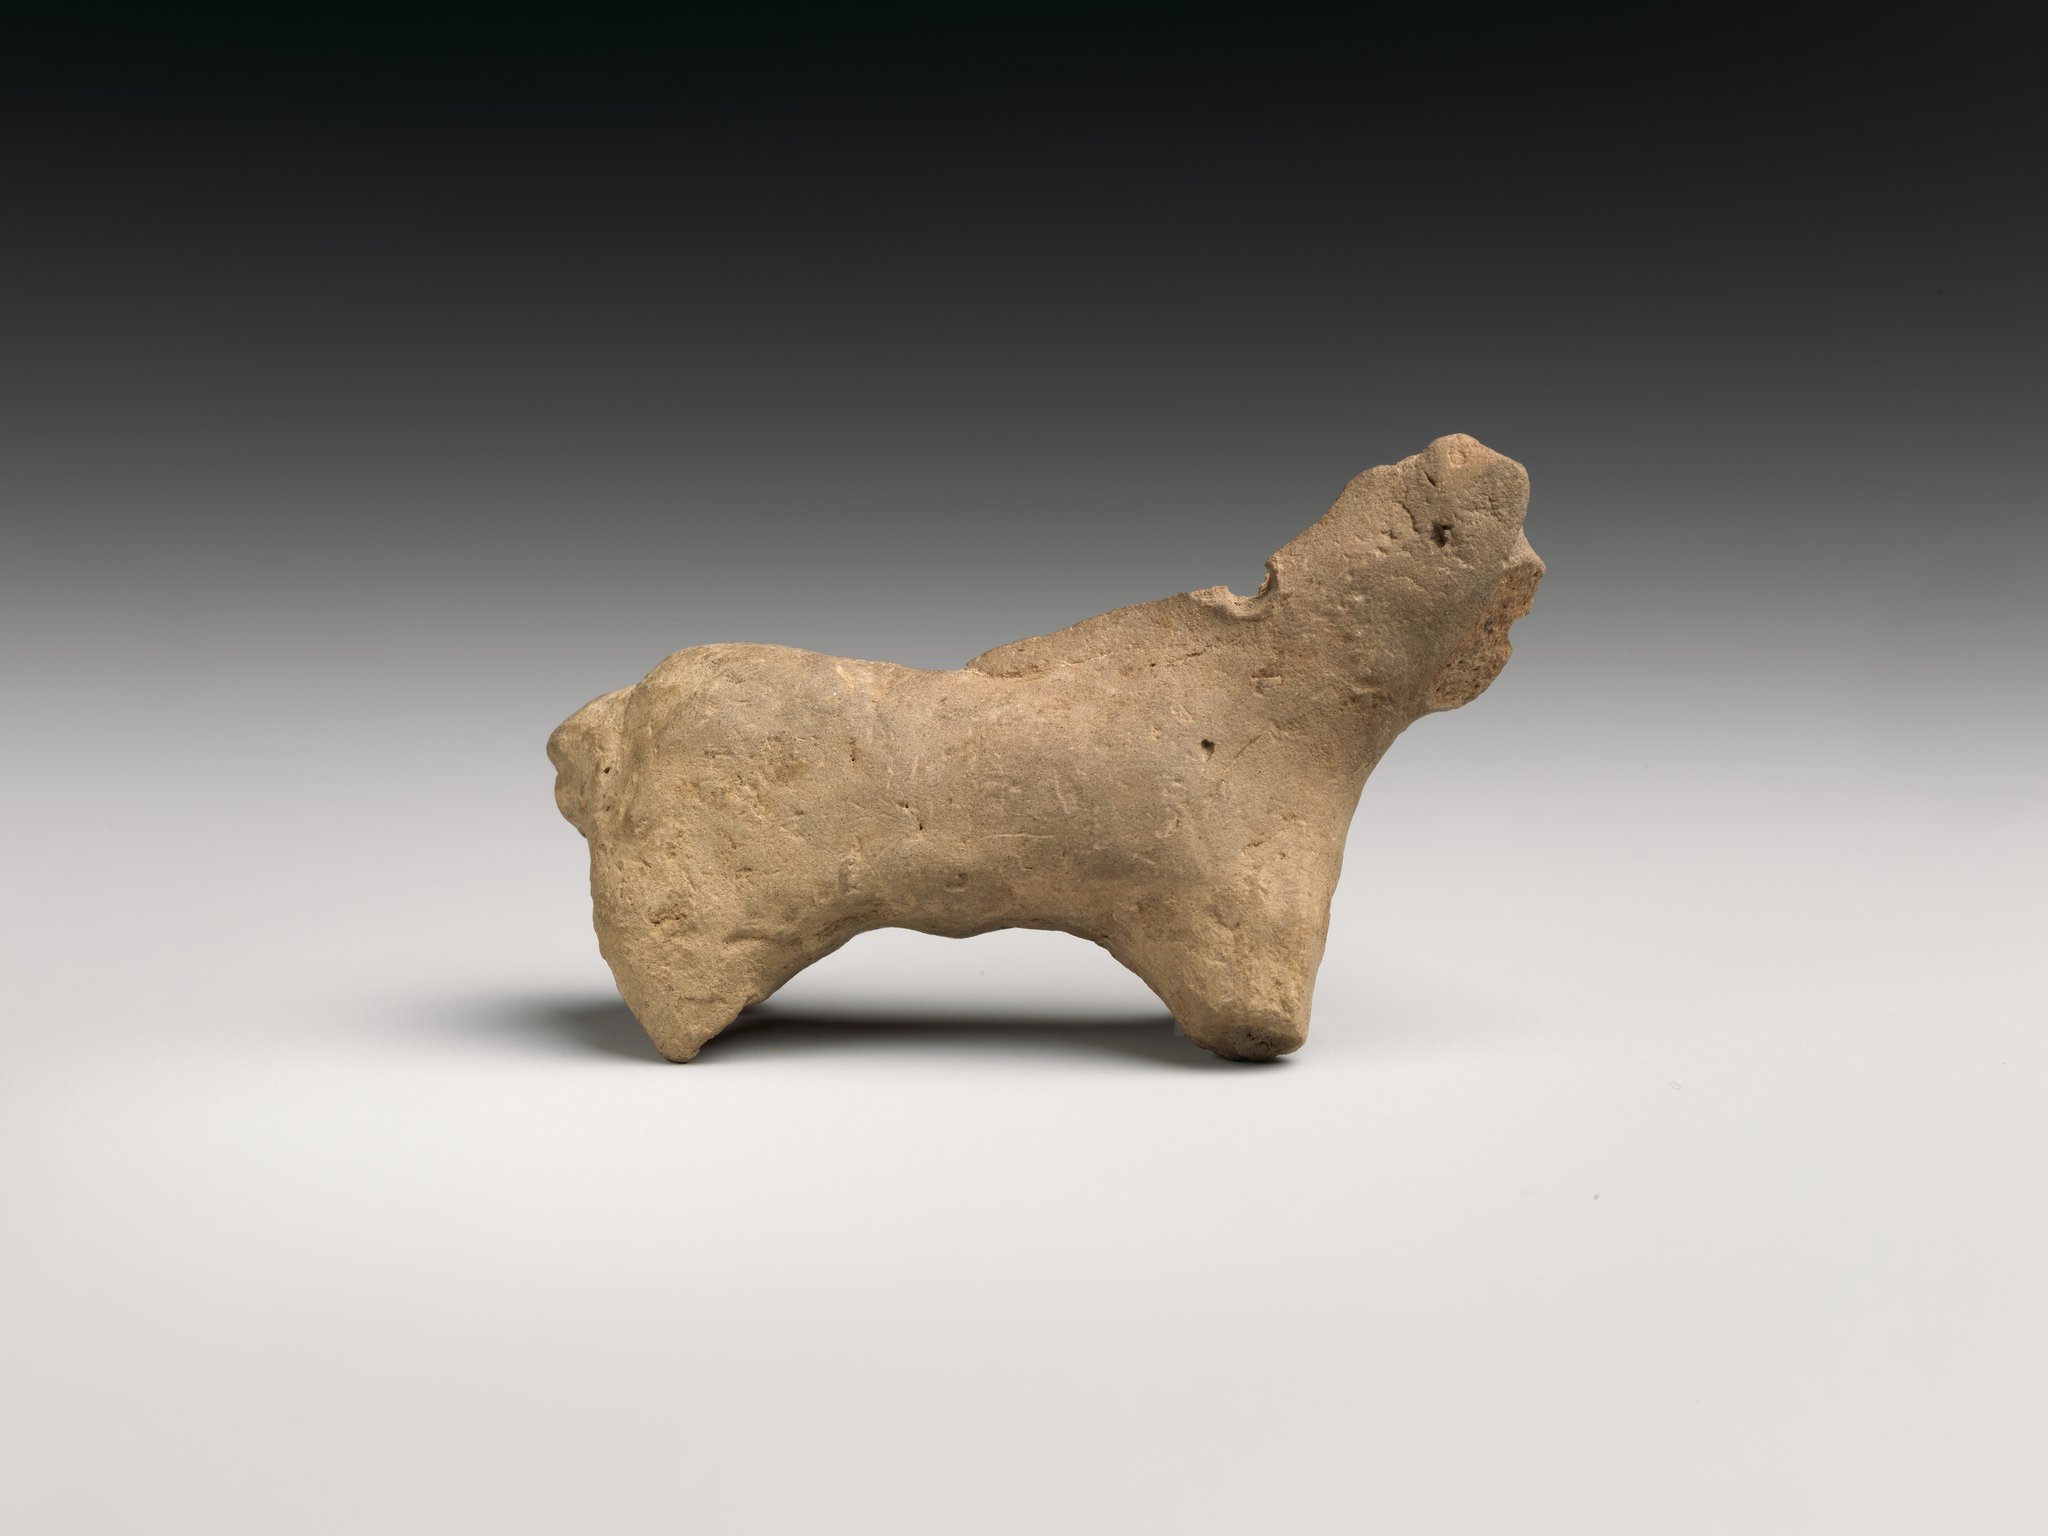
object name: necklace, bead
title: Standing animal amulet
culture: sumerian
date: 2600-2500 BCE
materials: ceramic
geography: mesopotamia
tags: animals